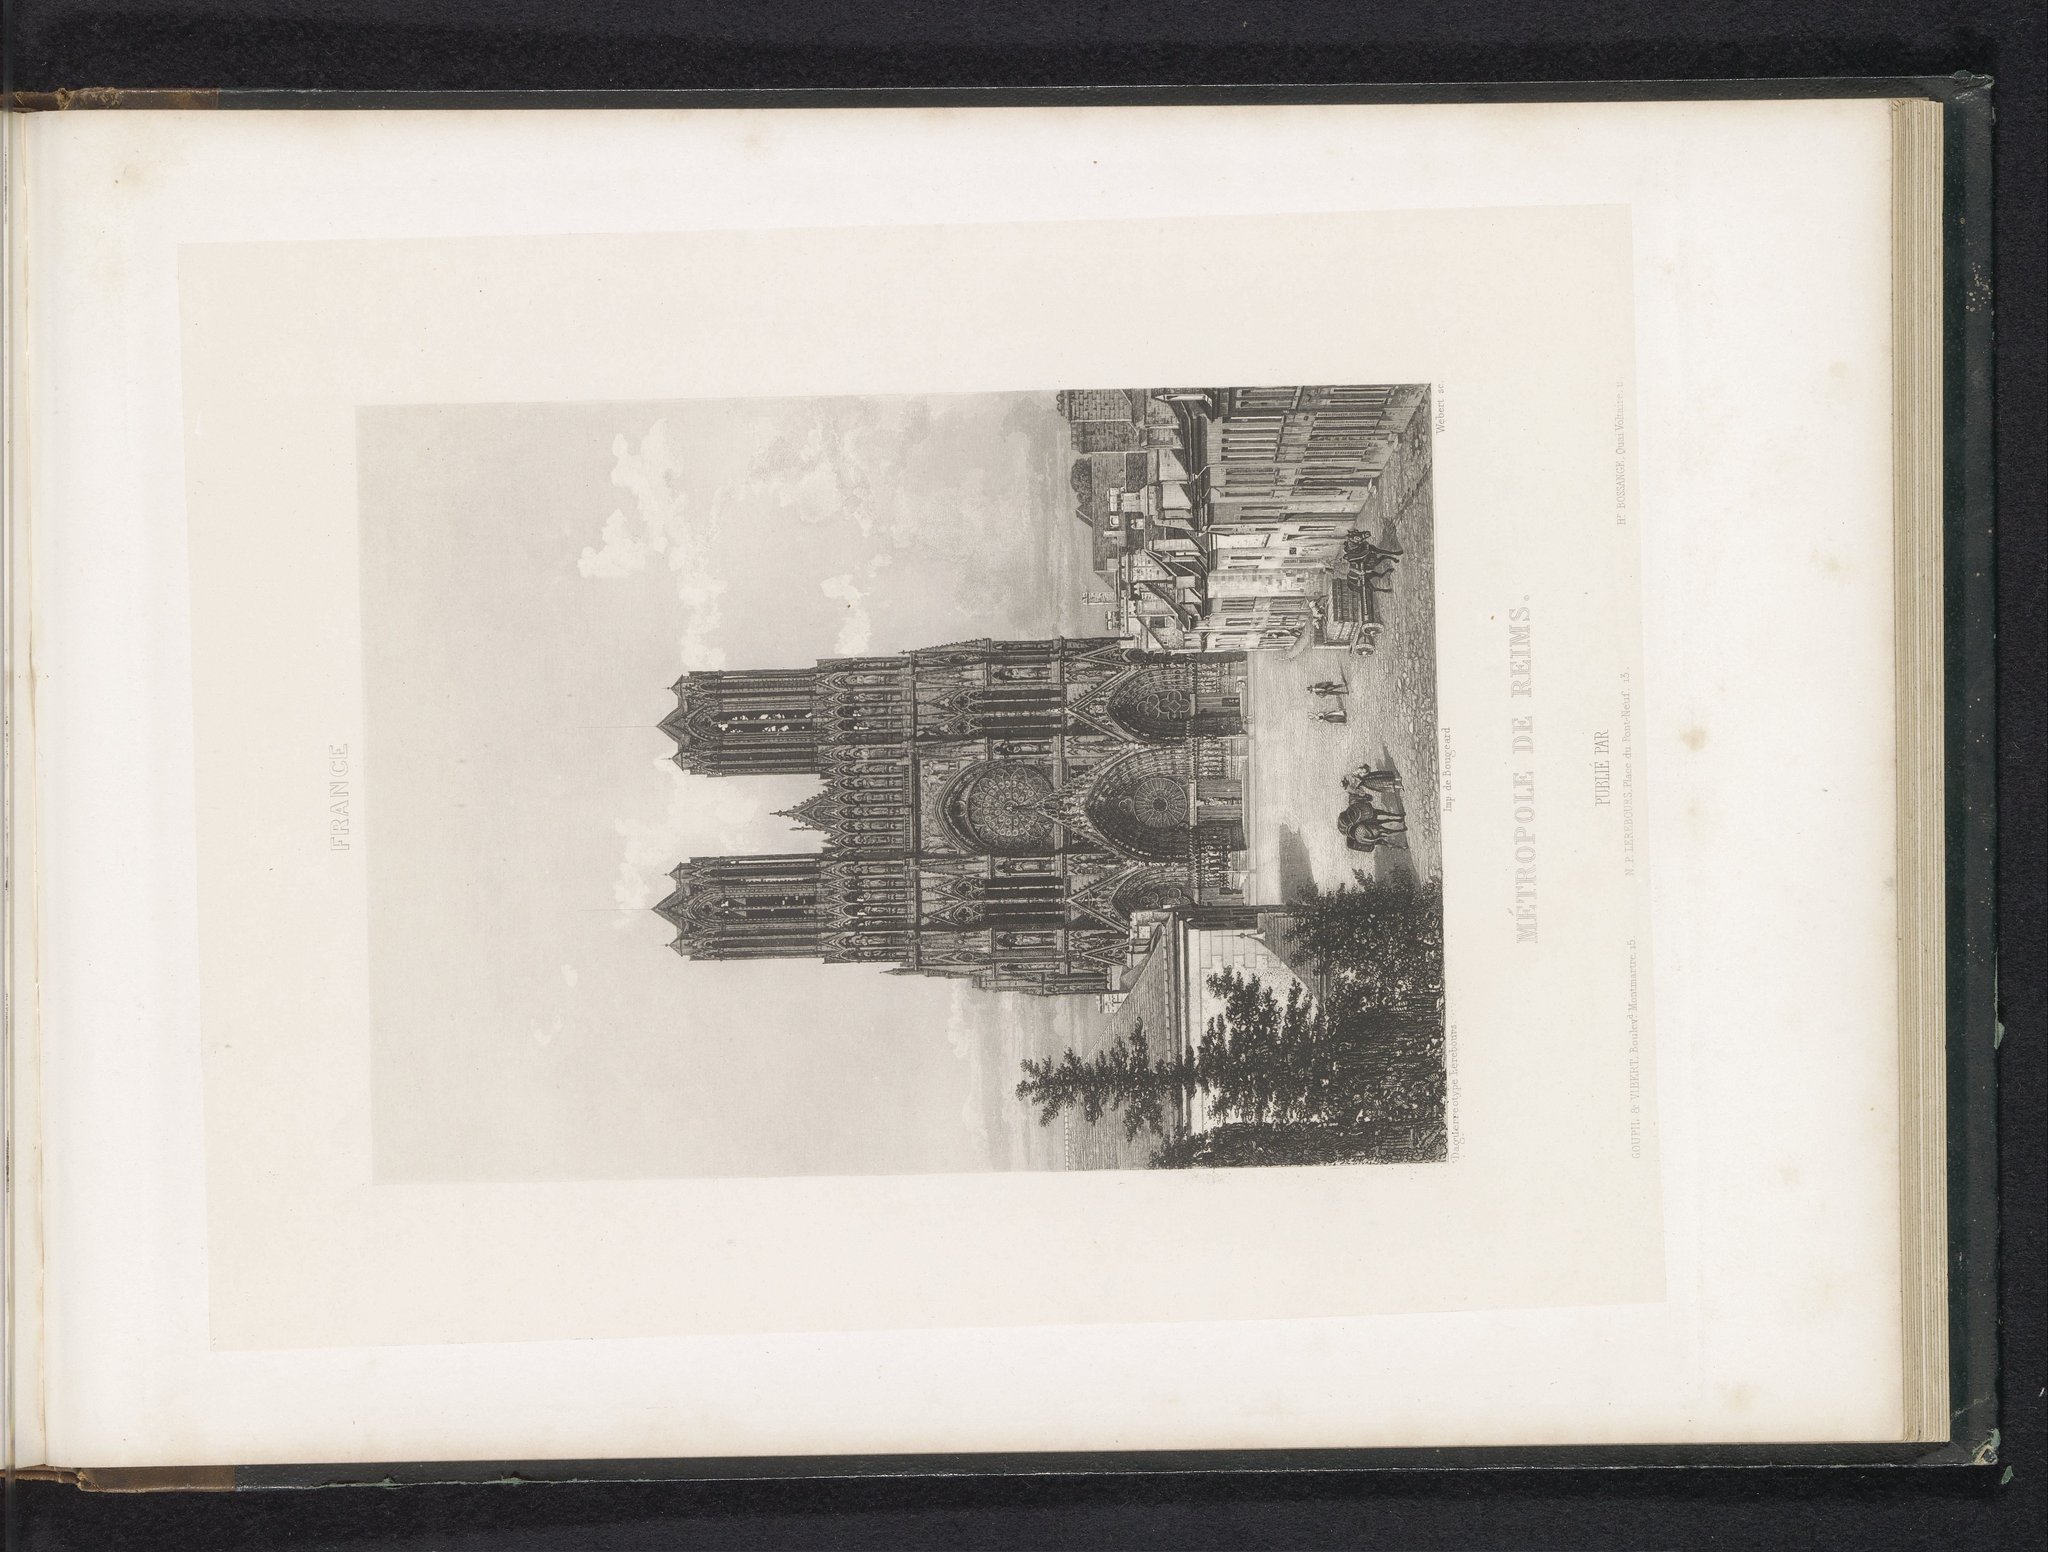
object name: page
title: France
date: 1839-1841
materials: paper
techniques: aquatint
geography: paris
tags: church (exterior), façade (of house or building)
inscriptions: inscription: ‘Rittner & Goupil Boulevd Montmartre 15’, inscription: ‘Hr. Bossance Quai Voltaire 11’, inscription: ‘N.P. Lerebours Place du Pont Neuf 15’